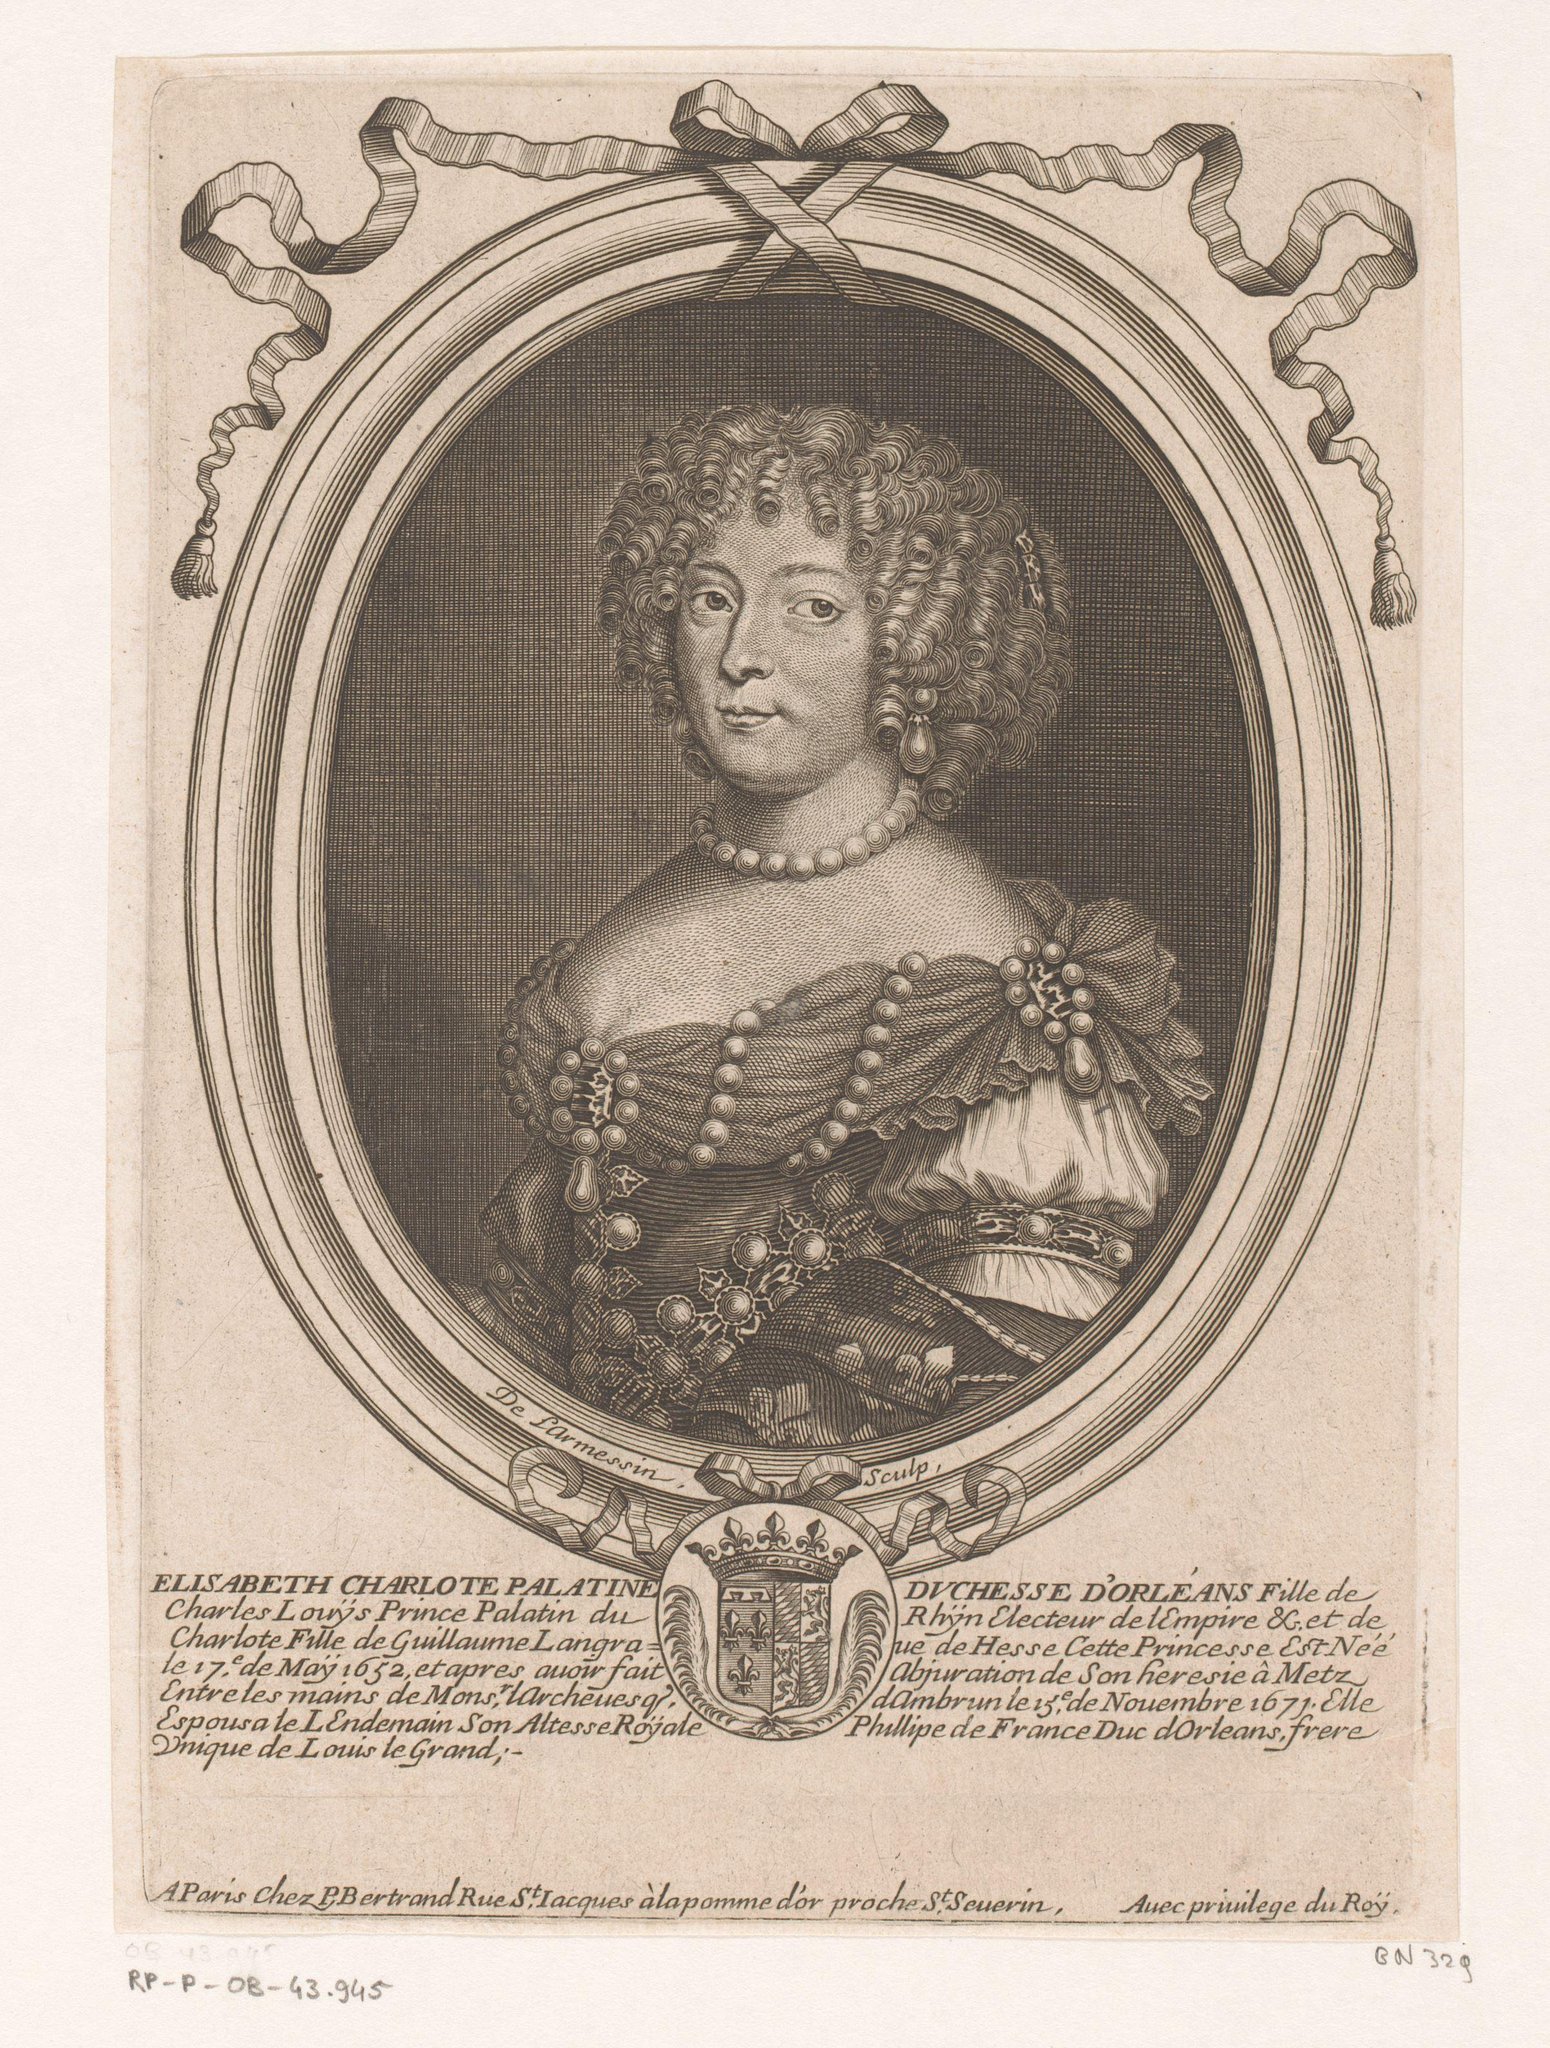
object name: print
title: Portretten van prominente figuren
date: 1642-1678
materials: paper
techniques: engraving, etching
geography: paris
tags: historical persons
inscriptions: collector's mark: Lugt 2228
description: Maakt deel uit van een grootschalige serie met portretten van prominente figuren. Binnen de serie bevindt zich een sectie getiteld 'Les Augustes Représentations De tous les Roys De France depuis Pharamond Iusqu'à Louys XIIII'. De serie werd respectievelijk uitgegeven door Pierre Bertrand, door zijn weduwe en door De Larmessin zelf.